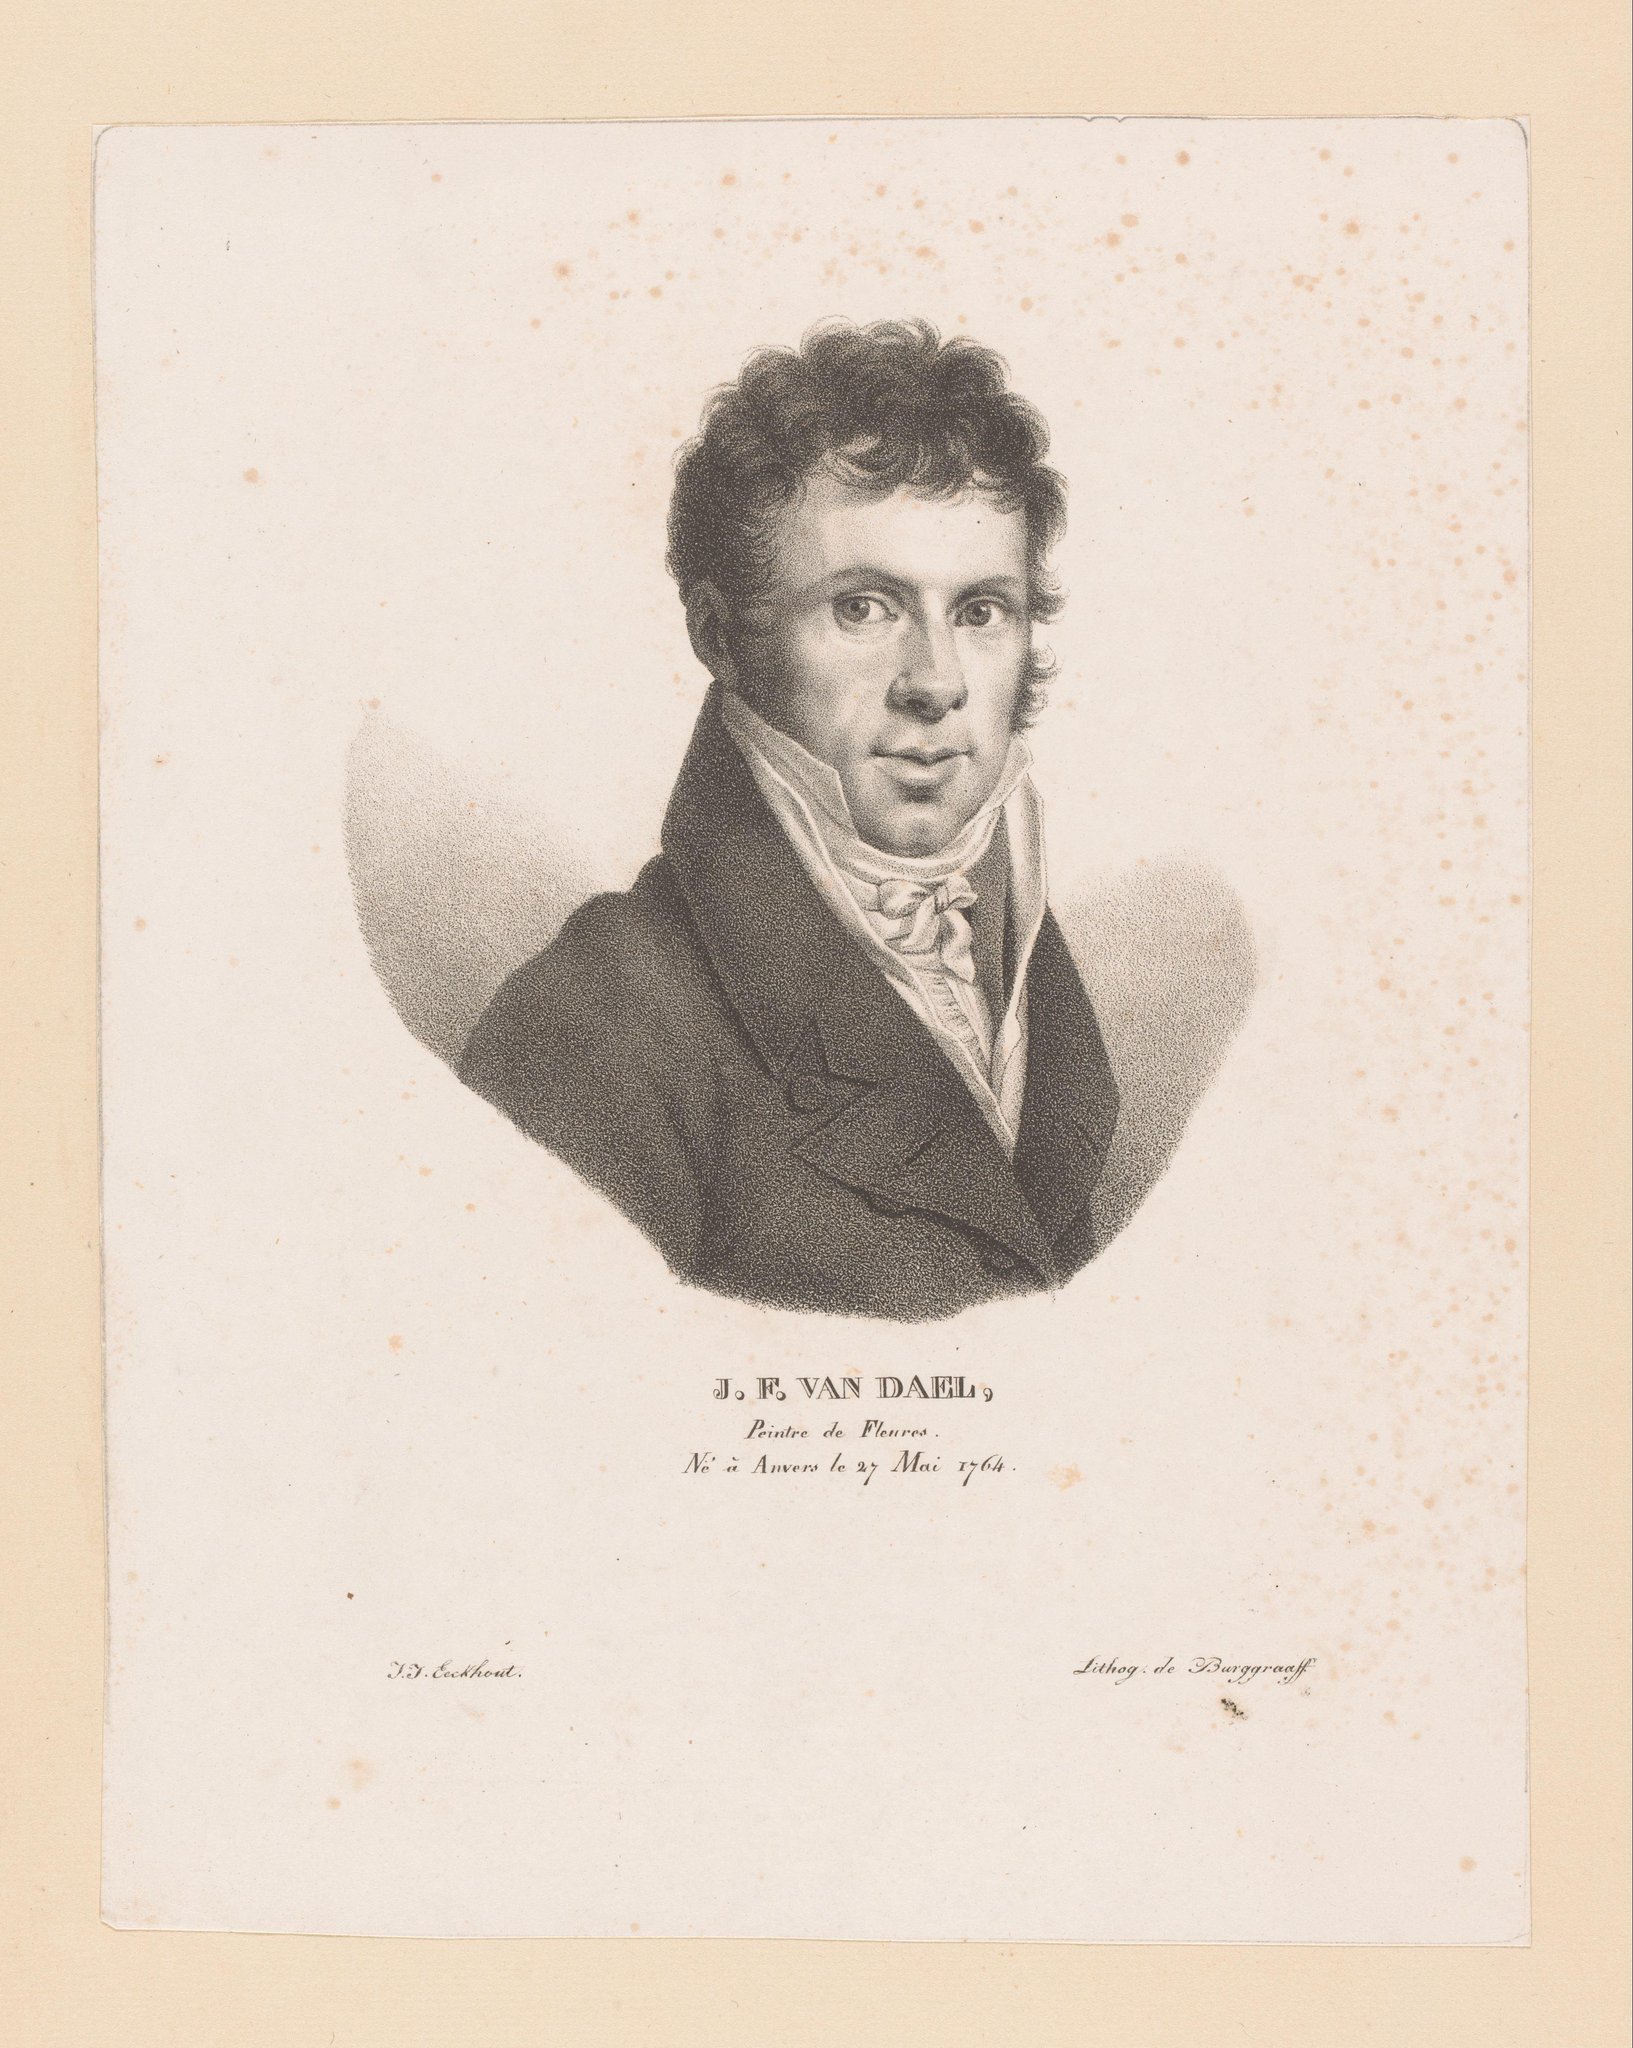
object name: print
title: Portretten van hedendaagse kunstenaars uit het Verenigd Koninkrijk der Nederlanden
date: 1822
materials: paper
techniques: lithograph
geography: brussels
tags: antwerp, paris, painter, draughtsman, jan frans van dael, historical persons, portrait, self-portrait of painter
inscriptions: collector's mark: Lugt 2228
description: Prent maakt deel uit van een serie van zestig prenten.